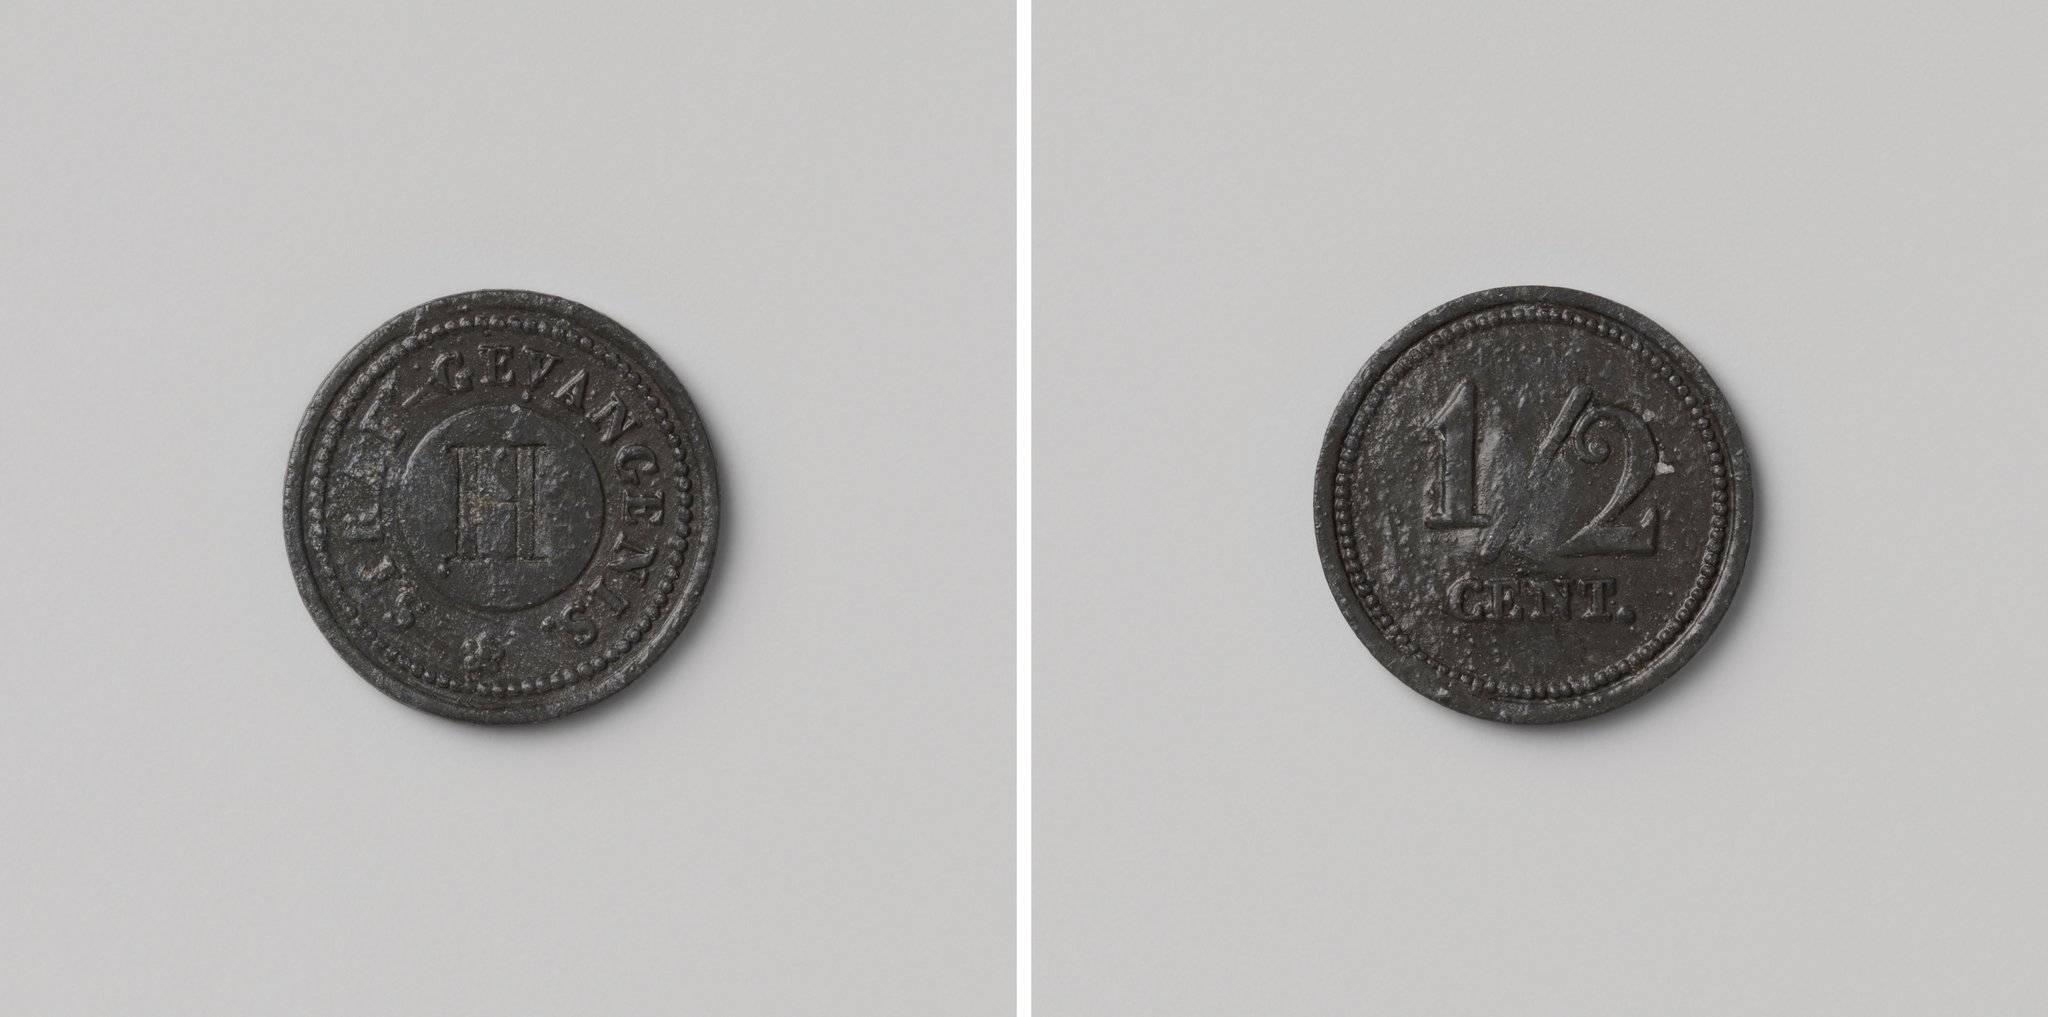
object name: huismunt prison money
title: Strafgevangenis te Hoorn, huismunt ter waarde van een halve cent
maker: Anonymous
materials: zinc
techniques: striking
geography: utrecht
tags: hoorn (north holland)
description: Zinken betaalpenning. Voorzijde: letter H binnen omschrift. Keerzijde: waardeaanduiding